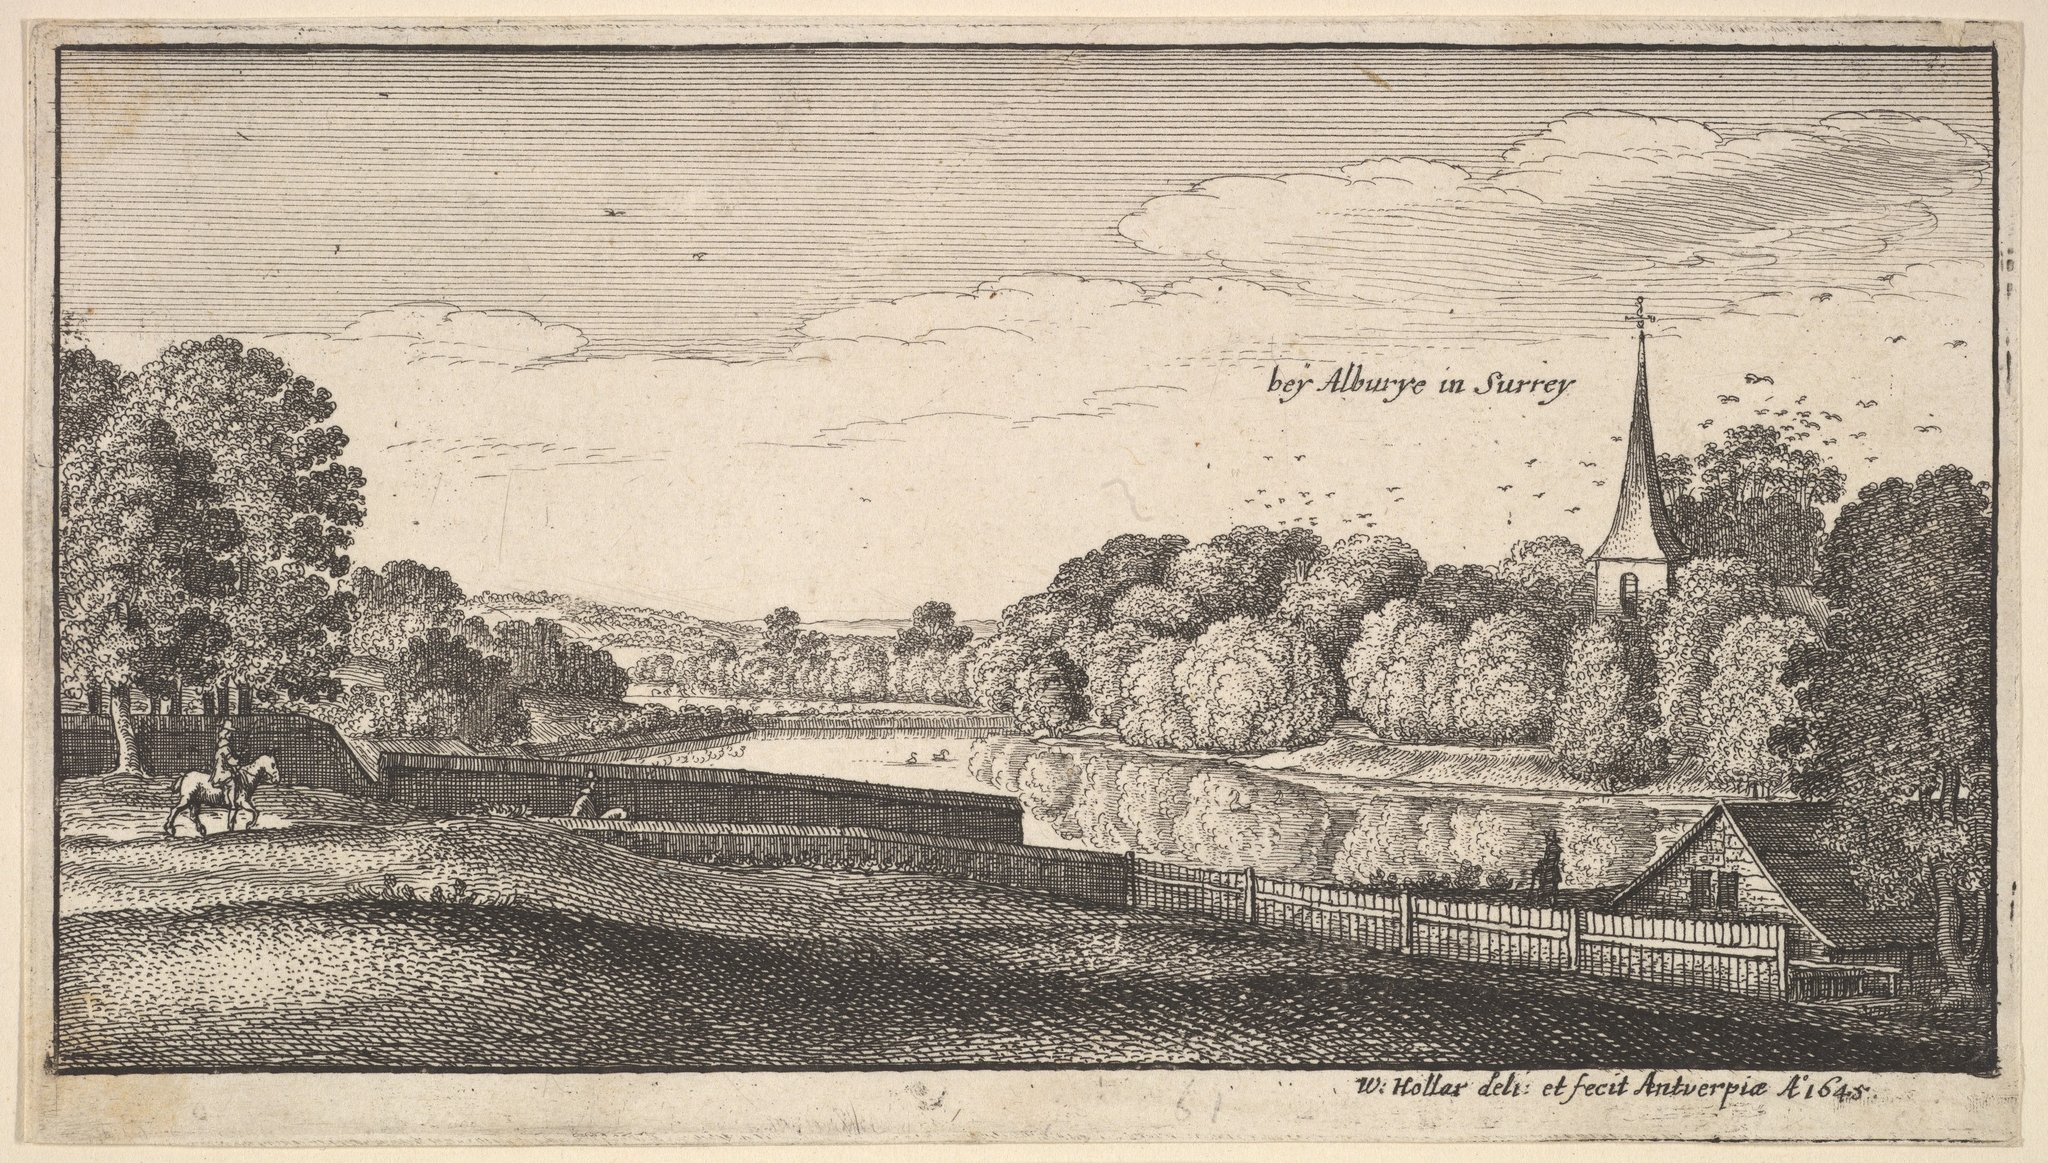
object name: print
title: View Near Albury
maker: wenceslaus hollar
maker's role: artist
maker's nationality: bohemian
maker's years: 1607-1677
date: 1645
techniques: etching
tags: horses,rivers,landscapes